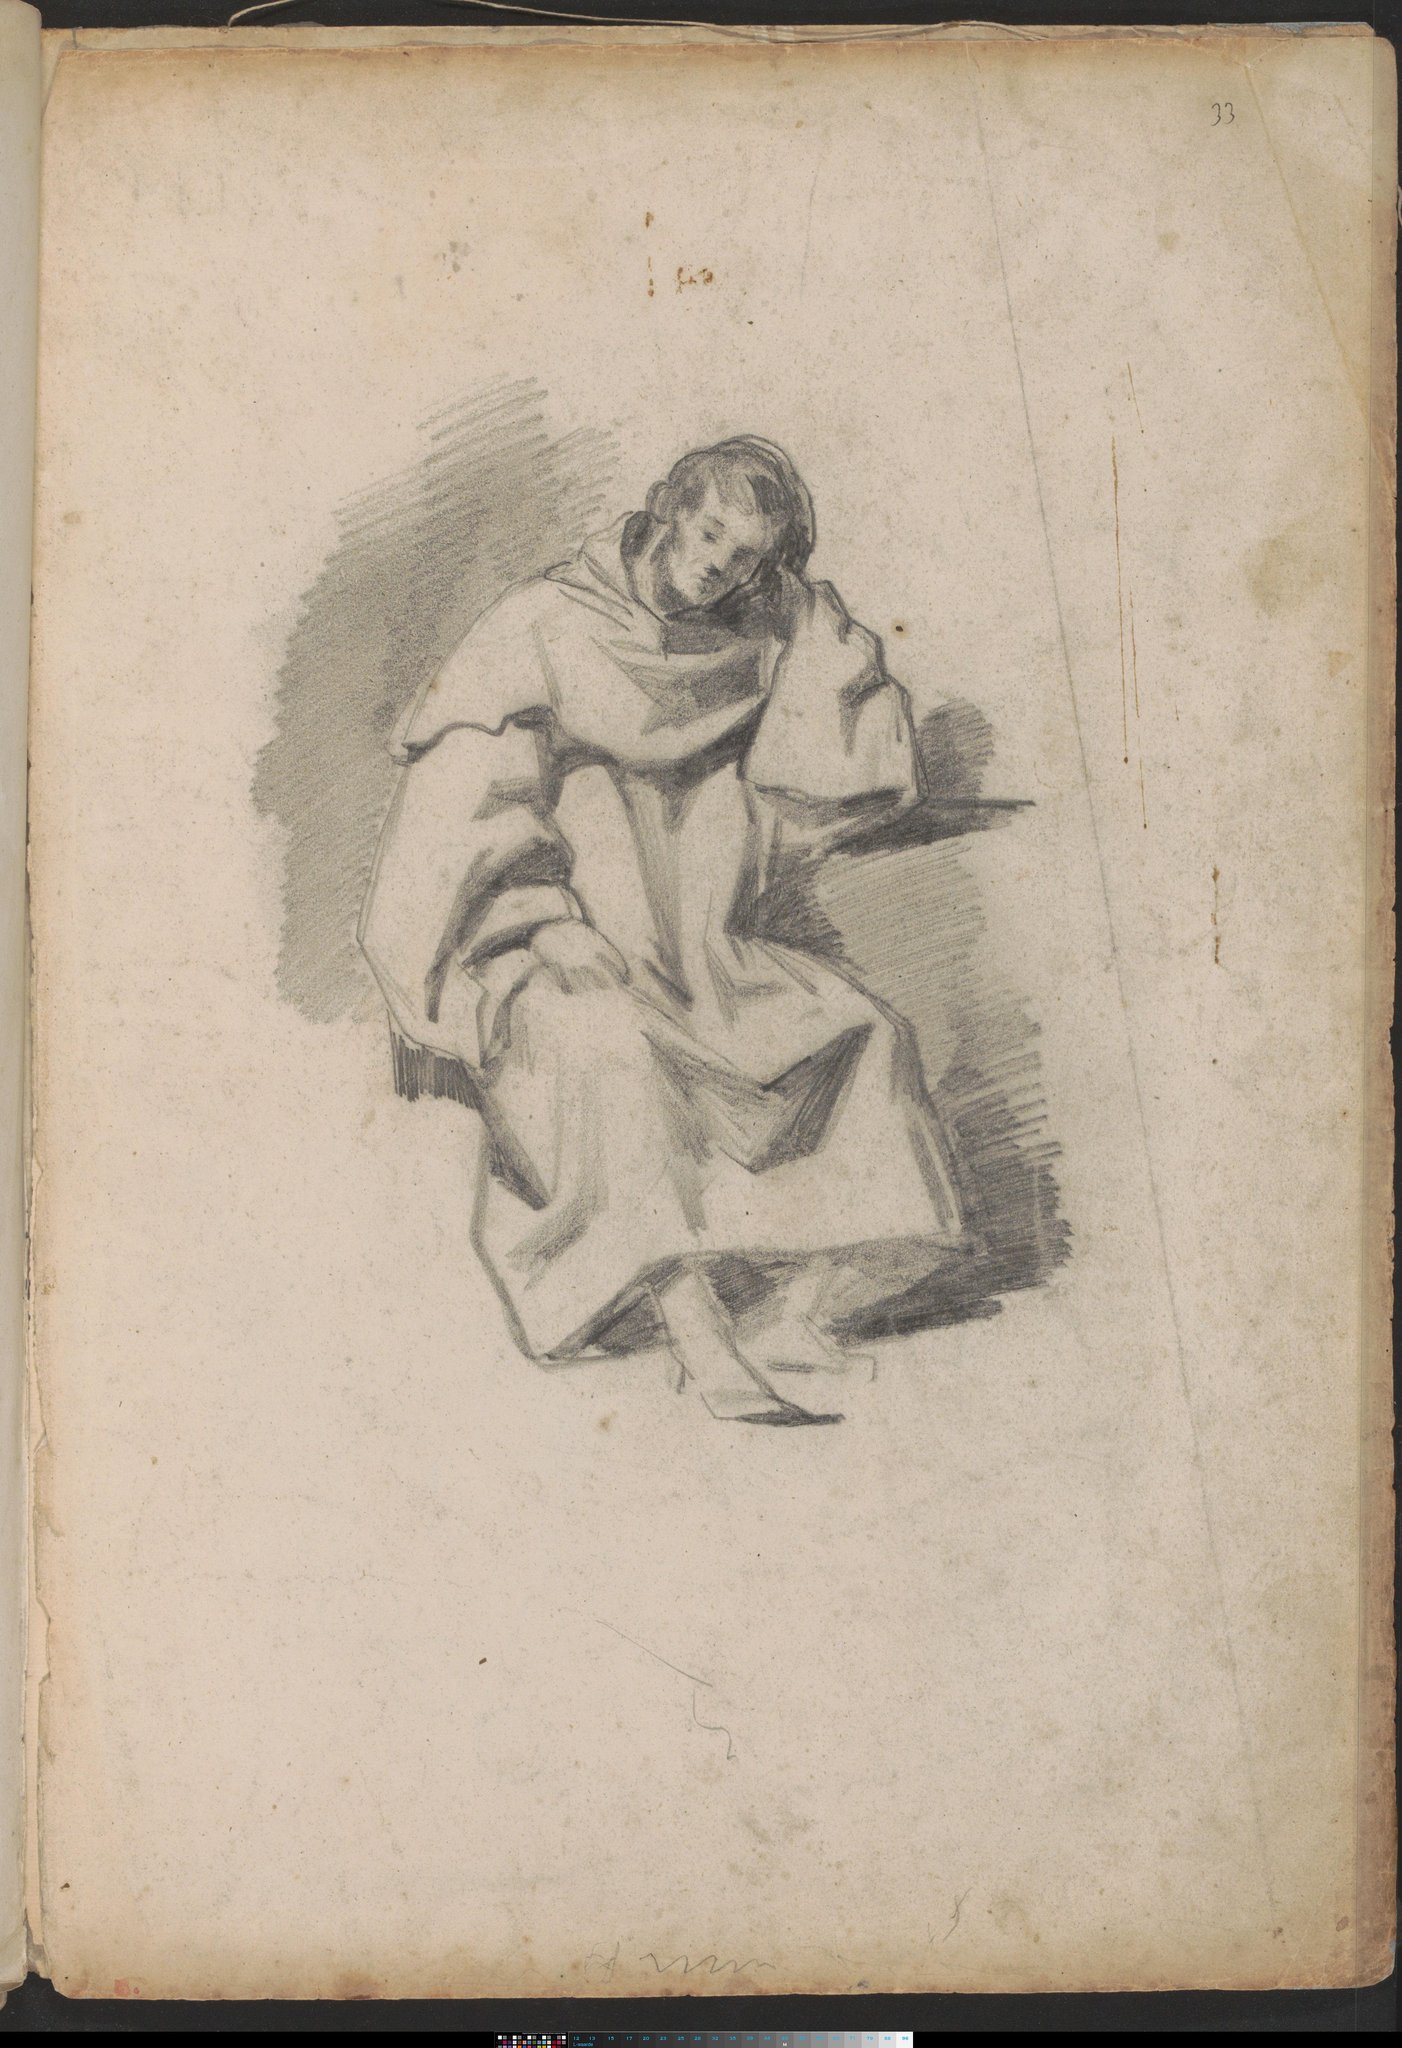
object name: sketchbook leaf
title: Zittende monnik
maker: johannes huybertus van hove bzn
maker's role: print maker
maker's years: 1827-1881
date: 1837-1881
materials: paper, pencil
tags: sitting figure, monk(s), friar(s)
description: Blad 33 recto uit een schetsboek met 33 bladen en 10 losse tekeningen.